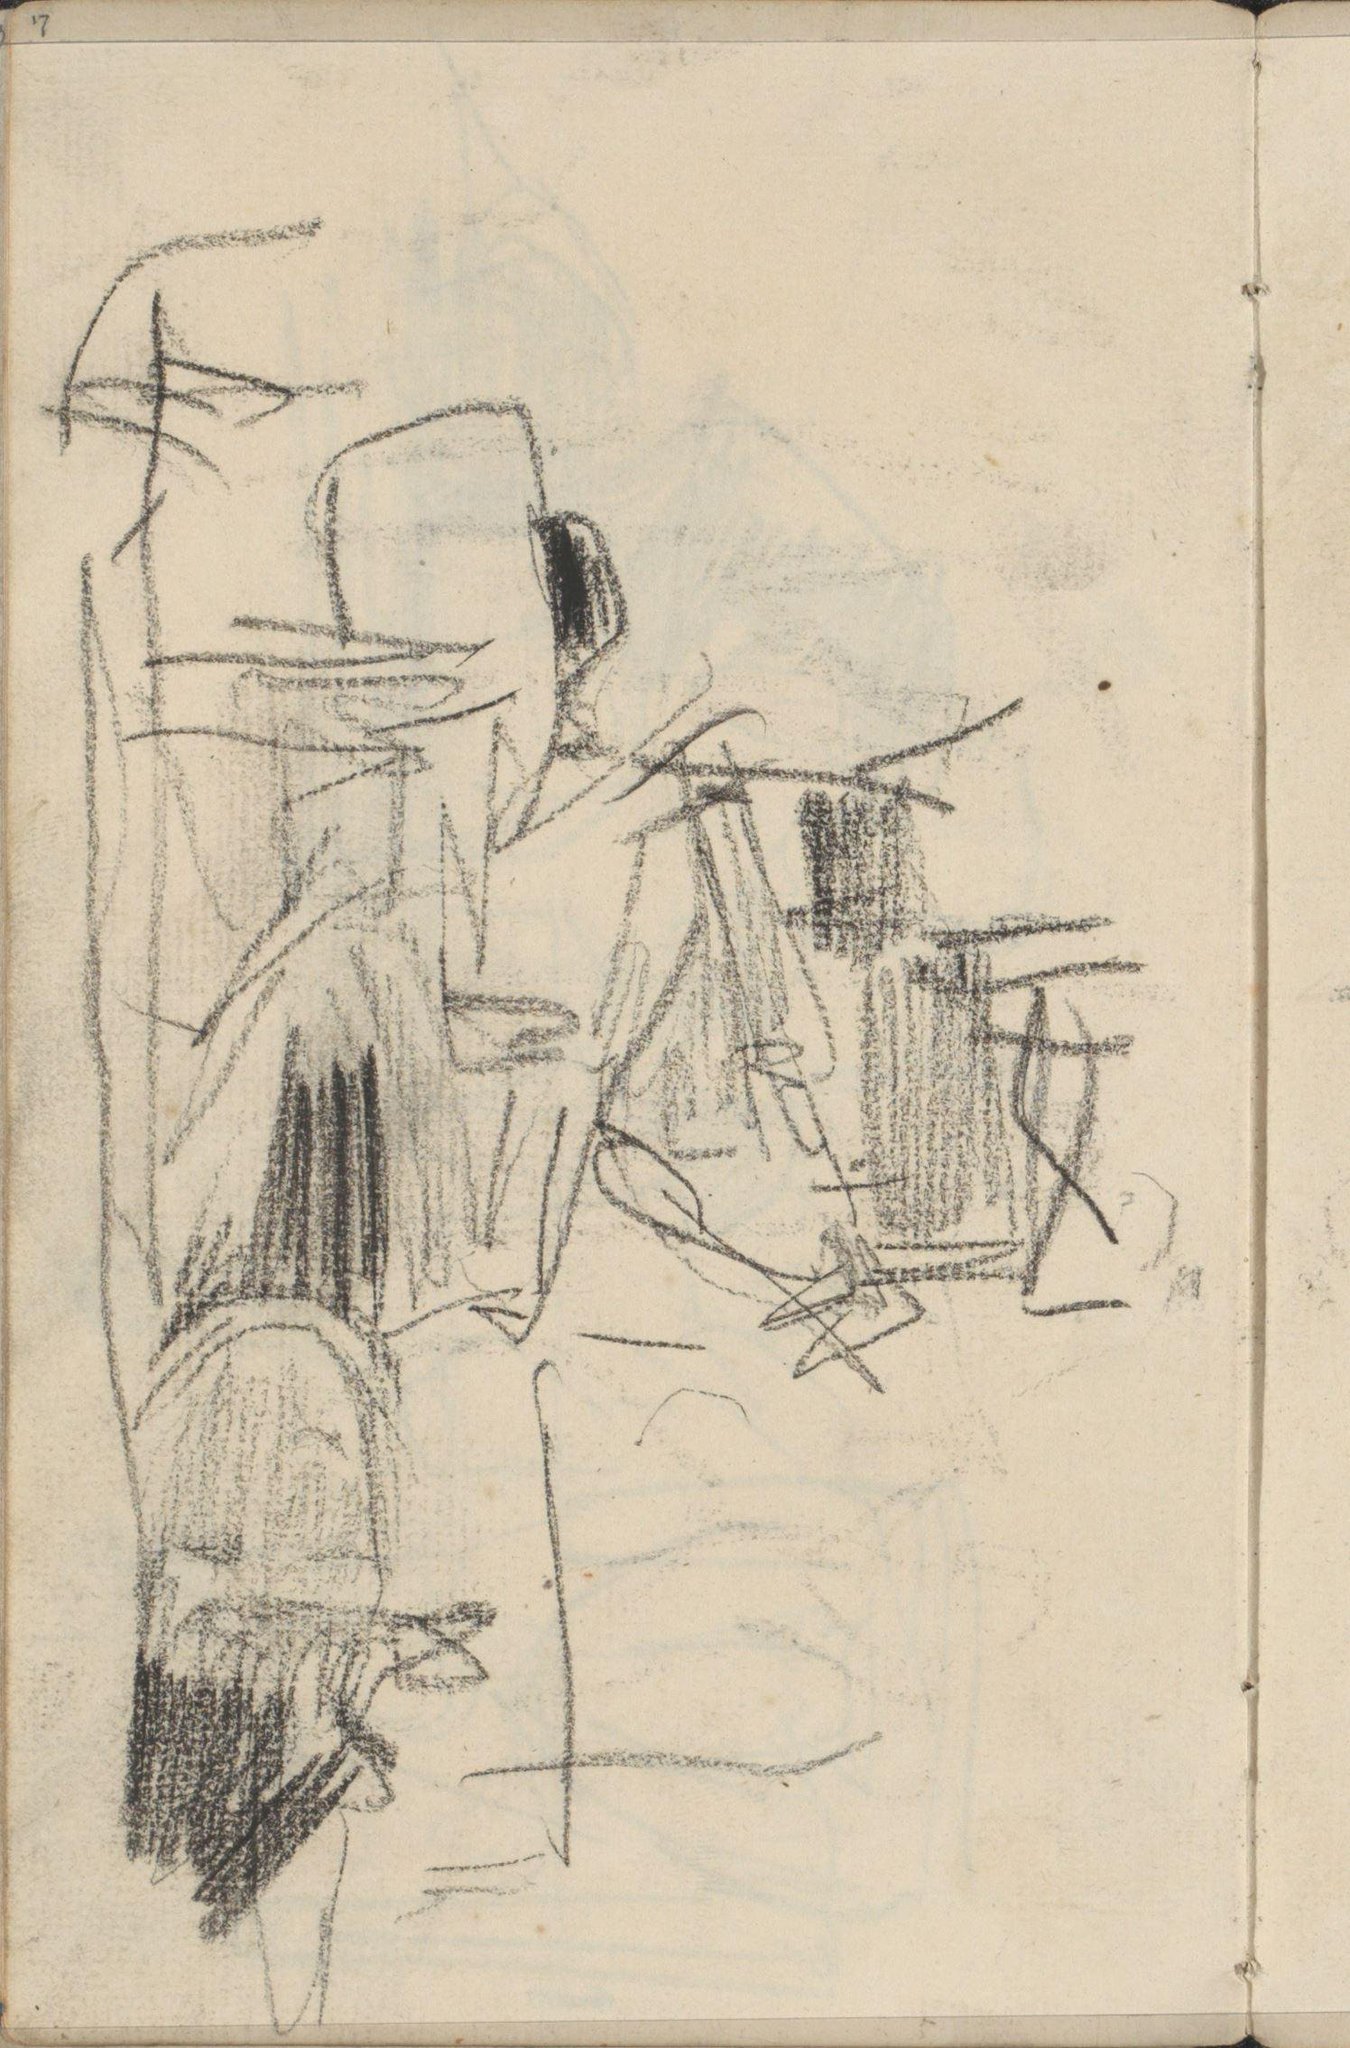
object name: sketchbook leaf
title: Studie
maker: george hendrik breitner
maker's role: draughtsman, painter, print maker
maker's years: 1857-1923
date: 1884-1886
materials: chalk, paper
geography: paris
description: Pagina 17 uit een schetsboek met 25 bladen.